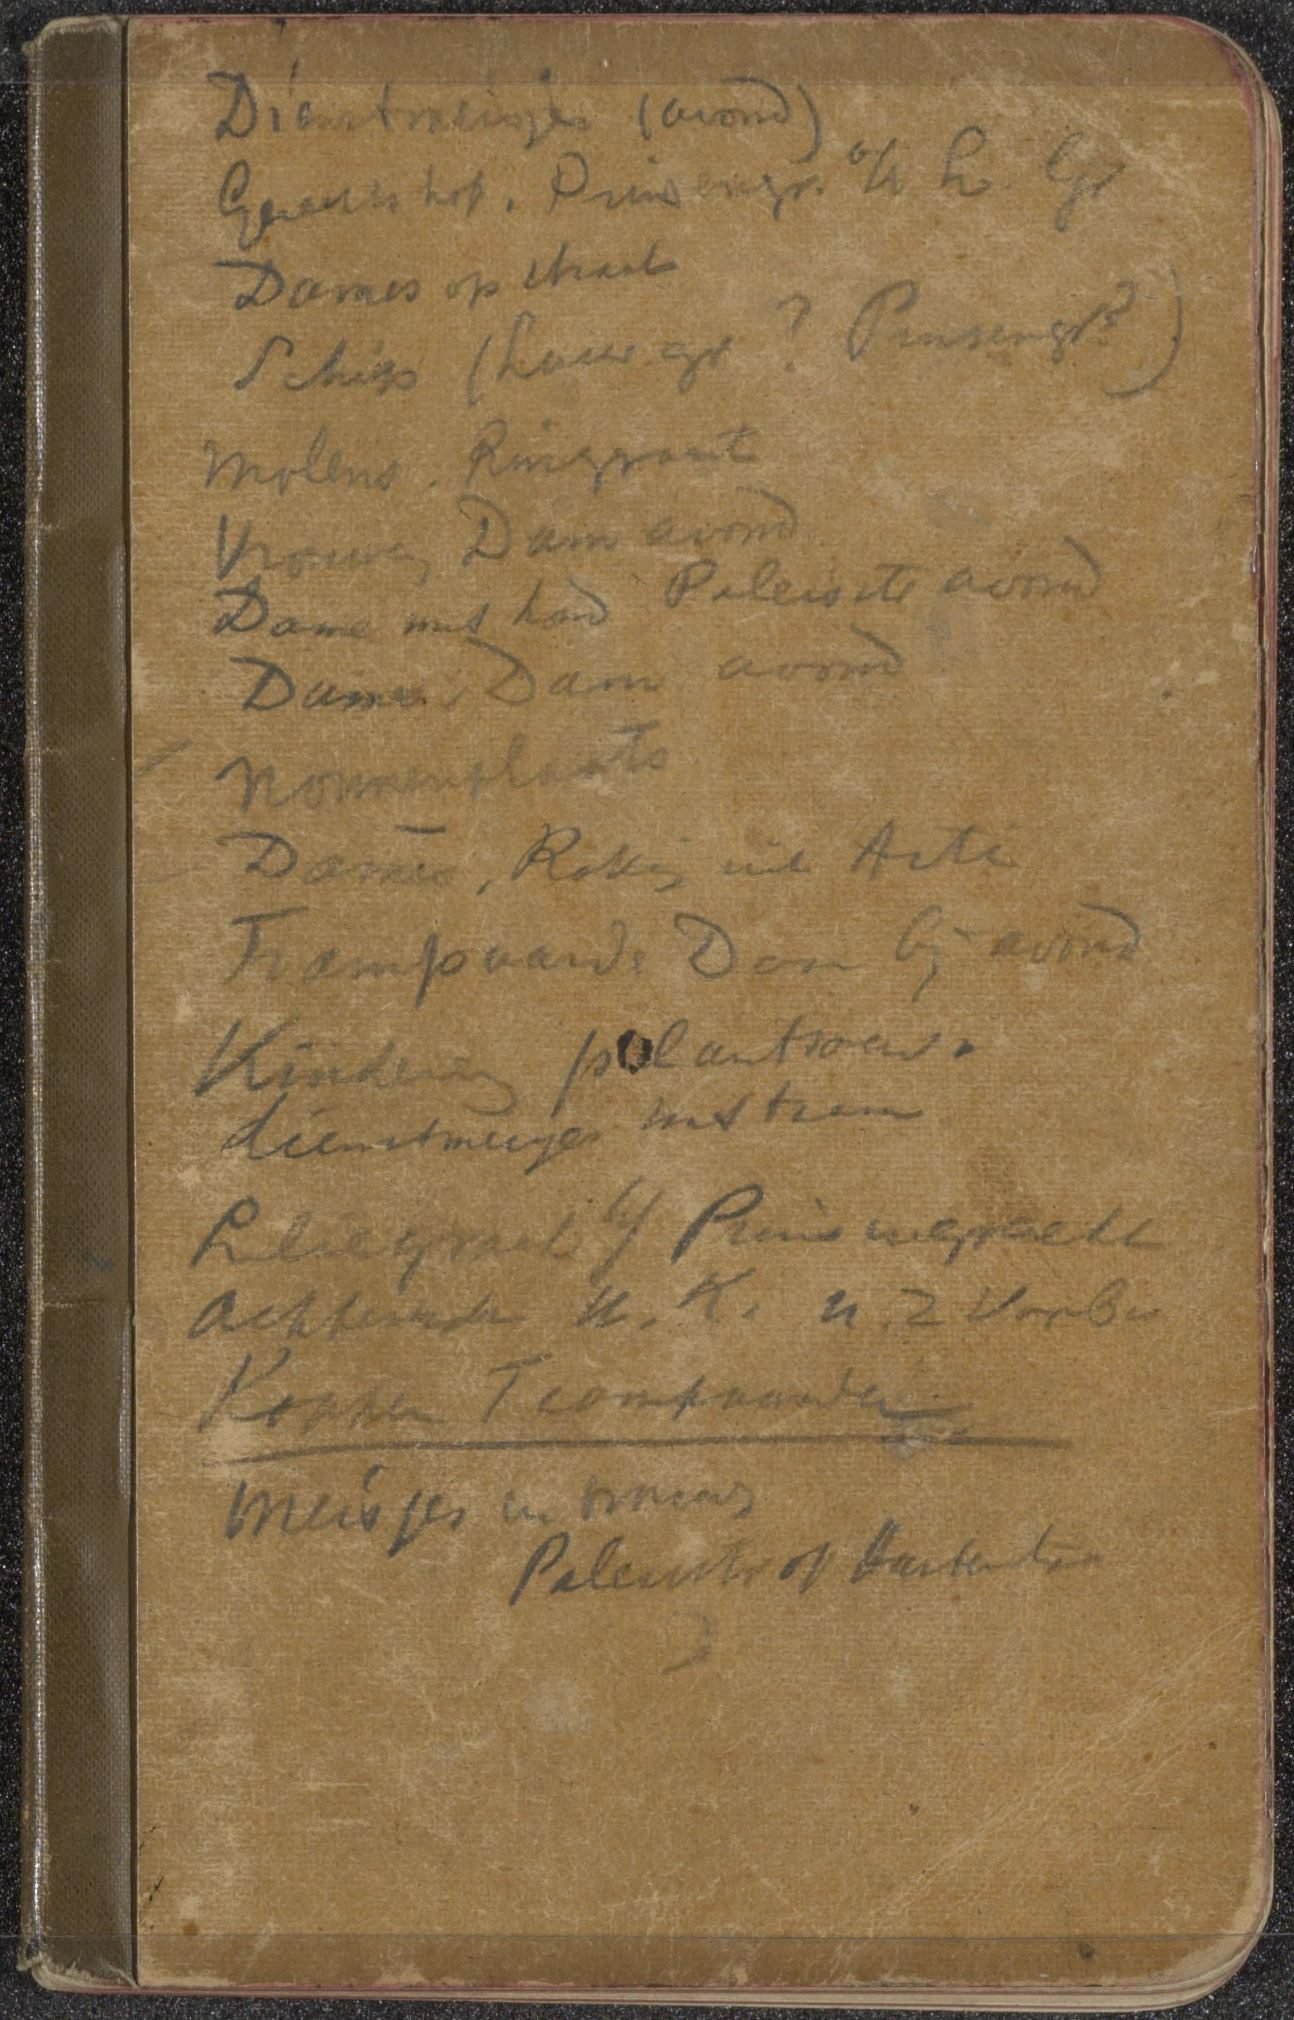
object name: sketchbook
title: Schetsboek met 38 bladen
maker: george hendrik breitner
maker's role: draughtsman, painter, print maker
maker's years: 1857-1923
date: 1893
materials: cardboard, chalk, linen, paper, pencil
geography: nijmegen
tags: cat, anonymous historical person portrayed alone, street, male sex; man, nijmegen, amsterdam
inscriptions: retailer's mark: ‘Voskuil/ Paleisstraat/ Amsterdam.’, annotation: ‘Dienstmeisjes (avond)/ Gerechtshof. Prinsengr. b/d L. Gr./ Dames op straat/ Schip (Lauriergr? Prinsengr?)/ Molens Ringvaart/ Vrouwen, Dam avond/ Dame met hond Paleisstr avond/ Dames, Dam avond/ Nonnenplaats/ Dames, Rokin uit Arti/ Trampaarden Dam bij avond/ Kinderen plantsoen./ Dienstmeisjes uit tram/ Leliegracht h/ Prinsengracht/ Achterzijde N.K. N.Z. Voorbu/ Koppen Trampaarden/ meisjes en/ Paleisstr of Hartenstr’, date: ‘7 mei 93’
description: Schetsboek bestaande uit 38 bladen met voornamelijk figuurstudies, gezichten te Amsterdam en katten.